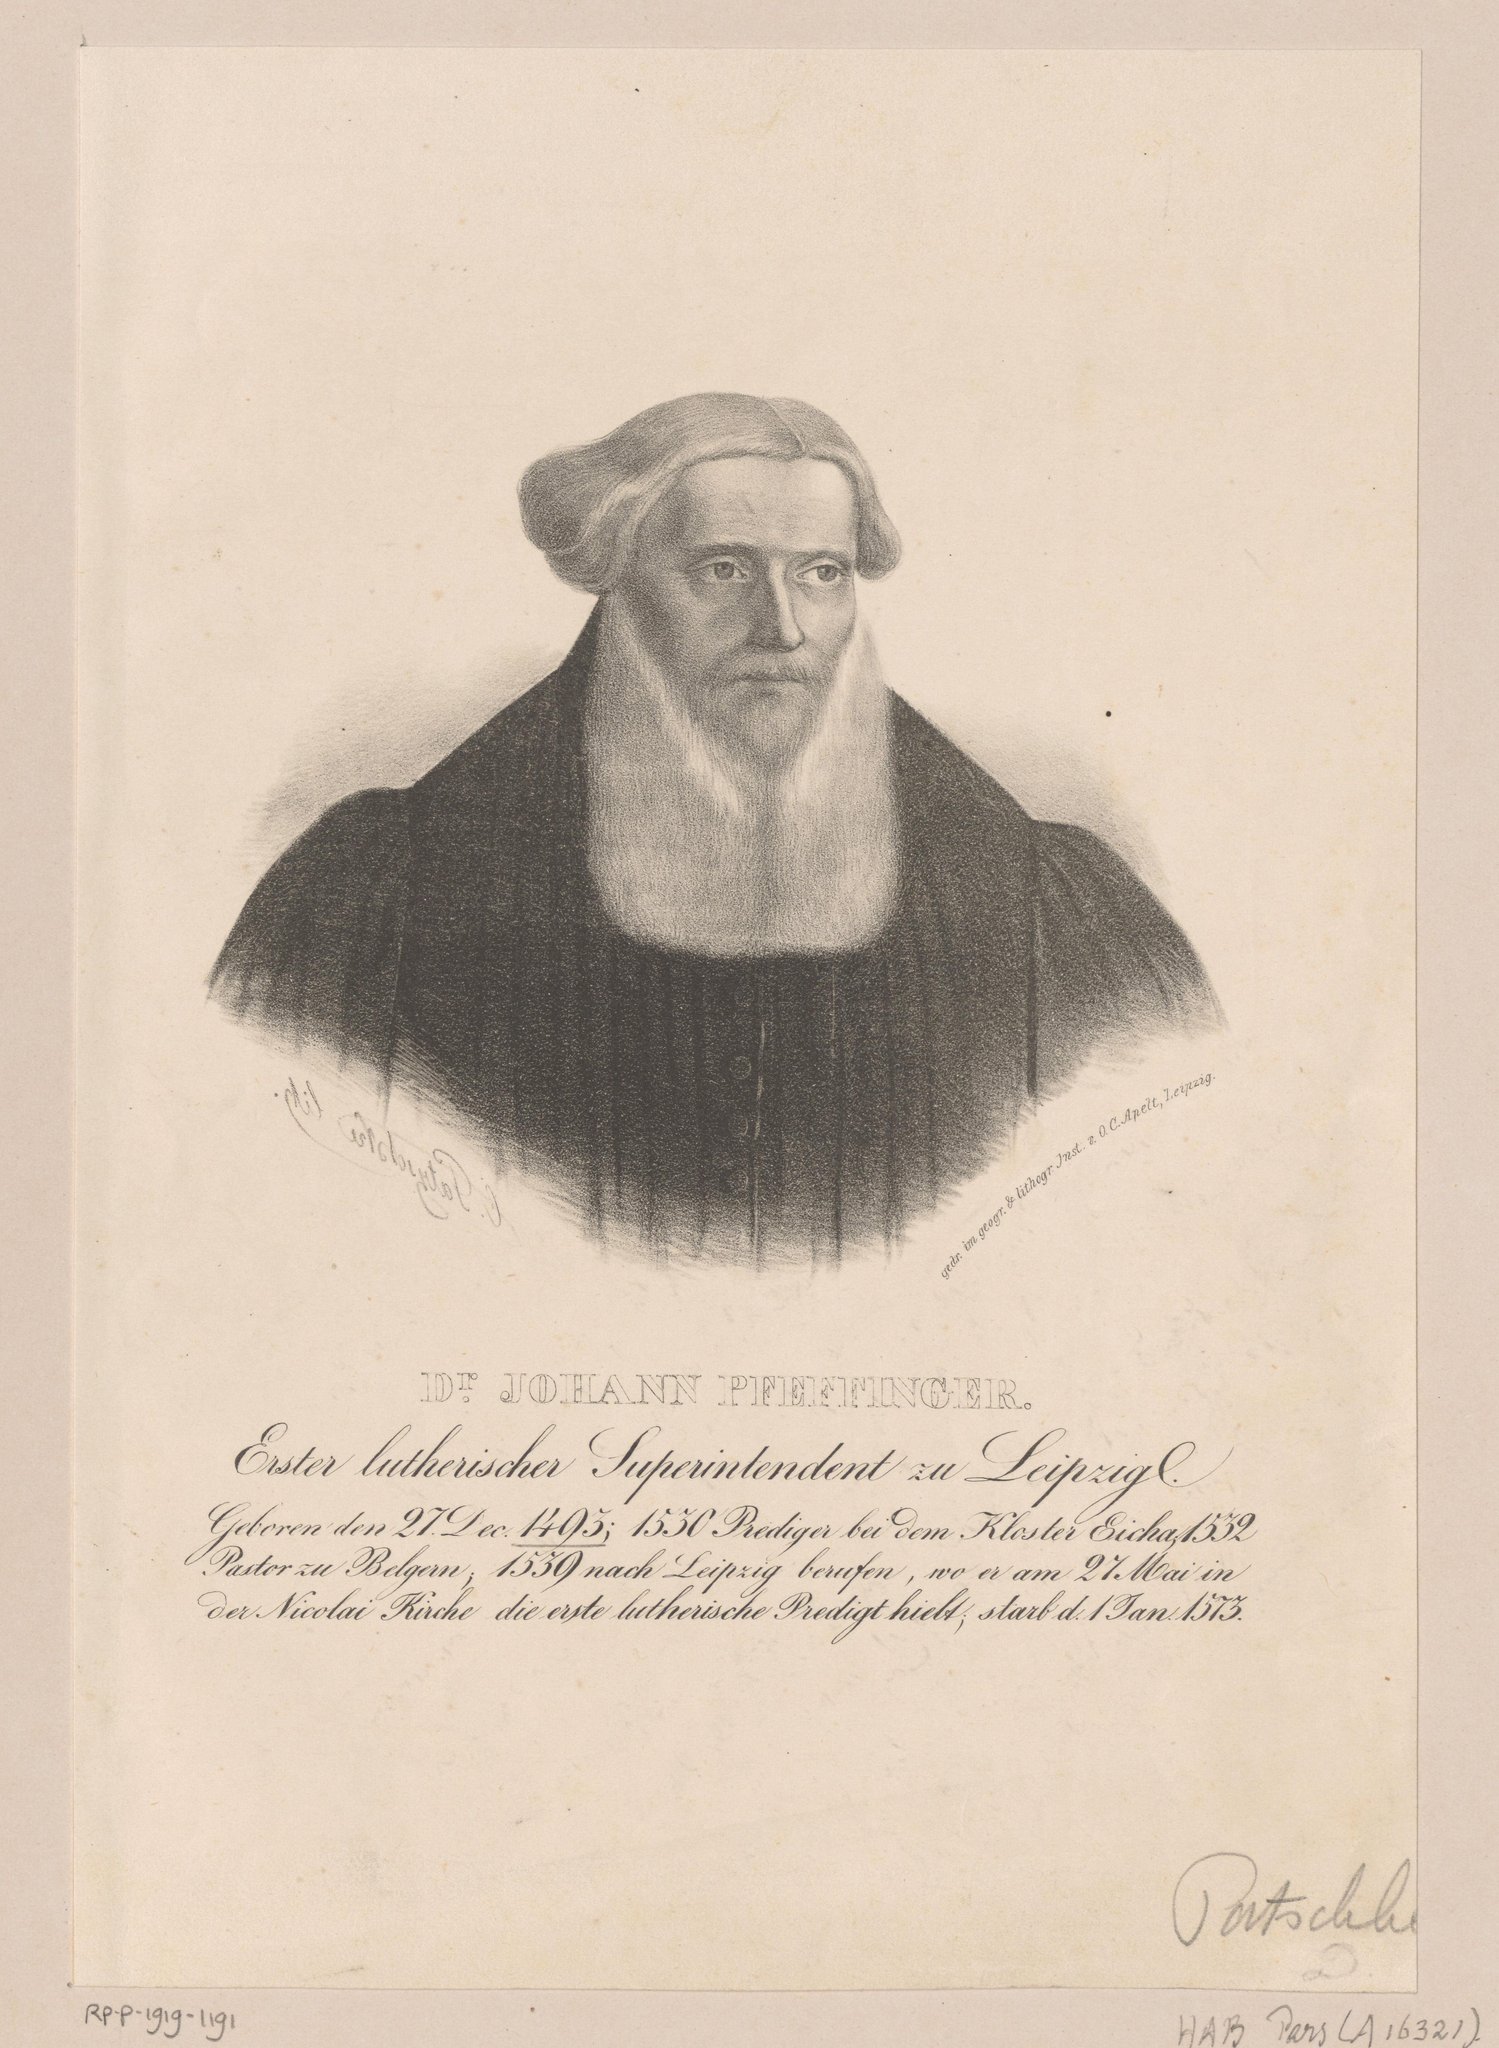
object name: print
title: Portret van Johann Pfeffinger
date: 1823-1871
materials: paper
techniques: lithograph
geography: leipzig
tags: adult man, historical persons, beard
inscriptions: collector's mark: Lugt 2228